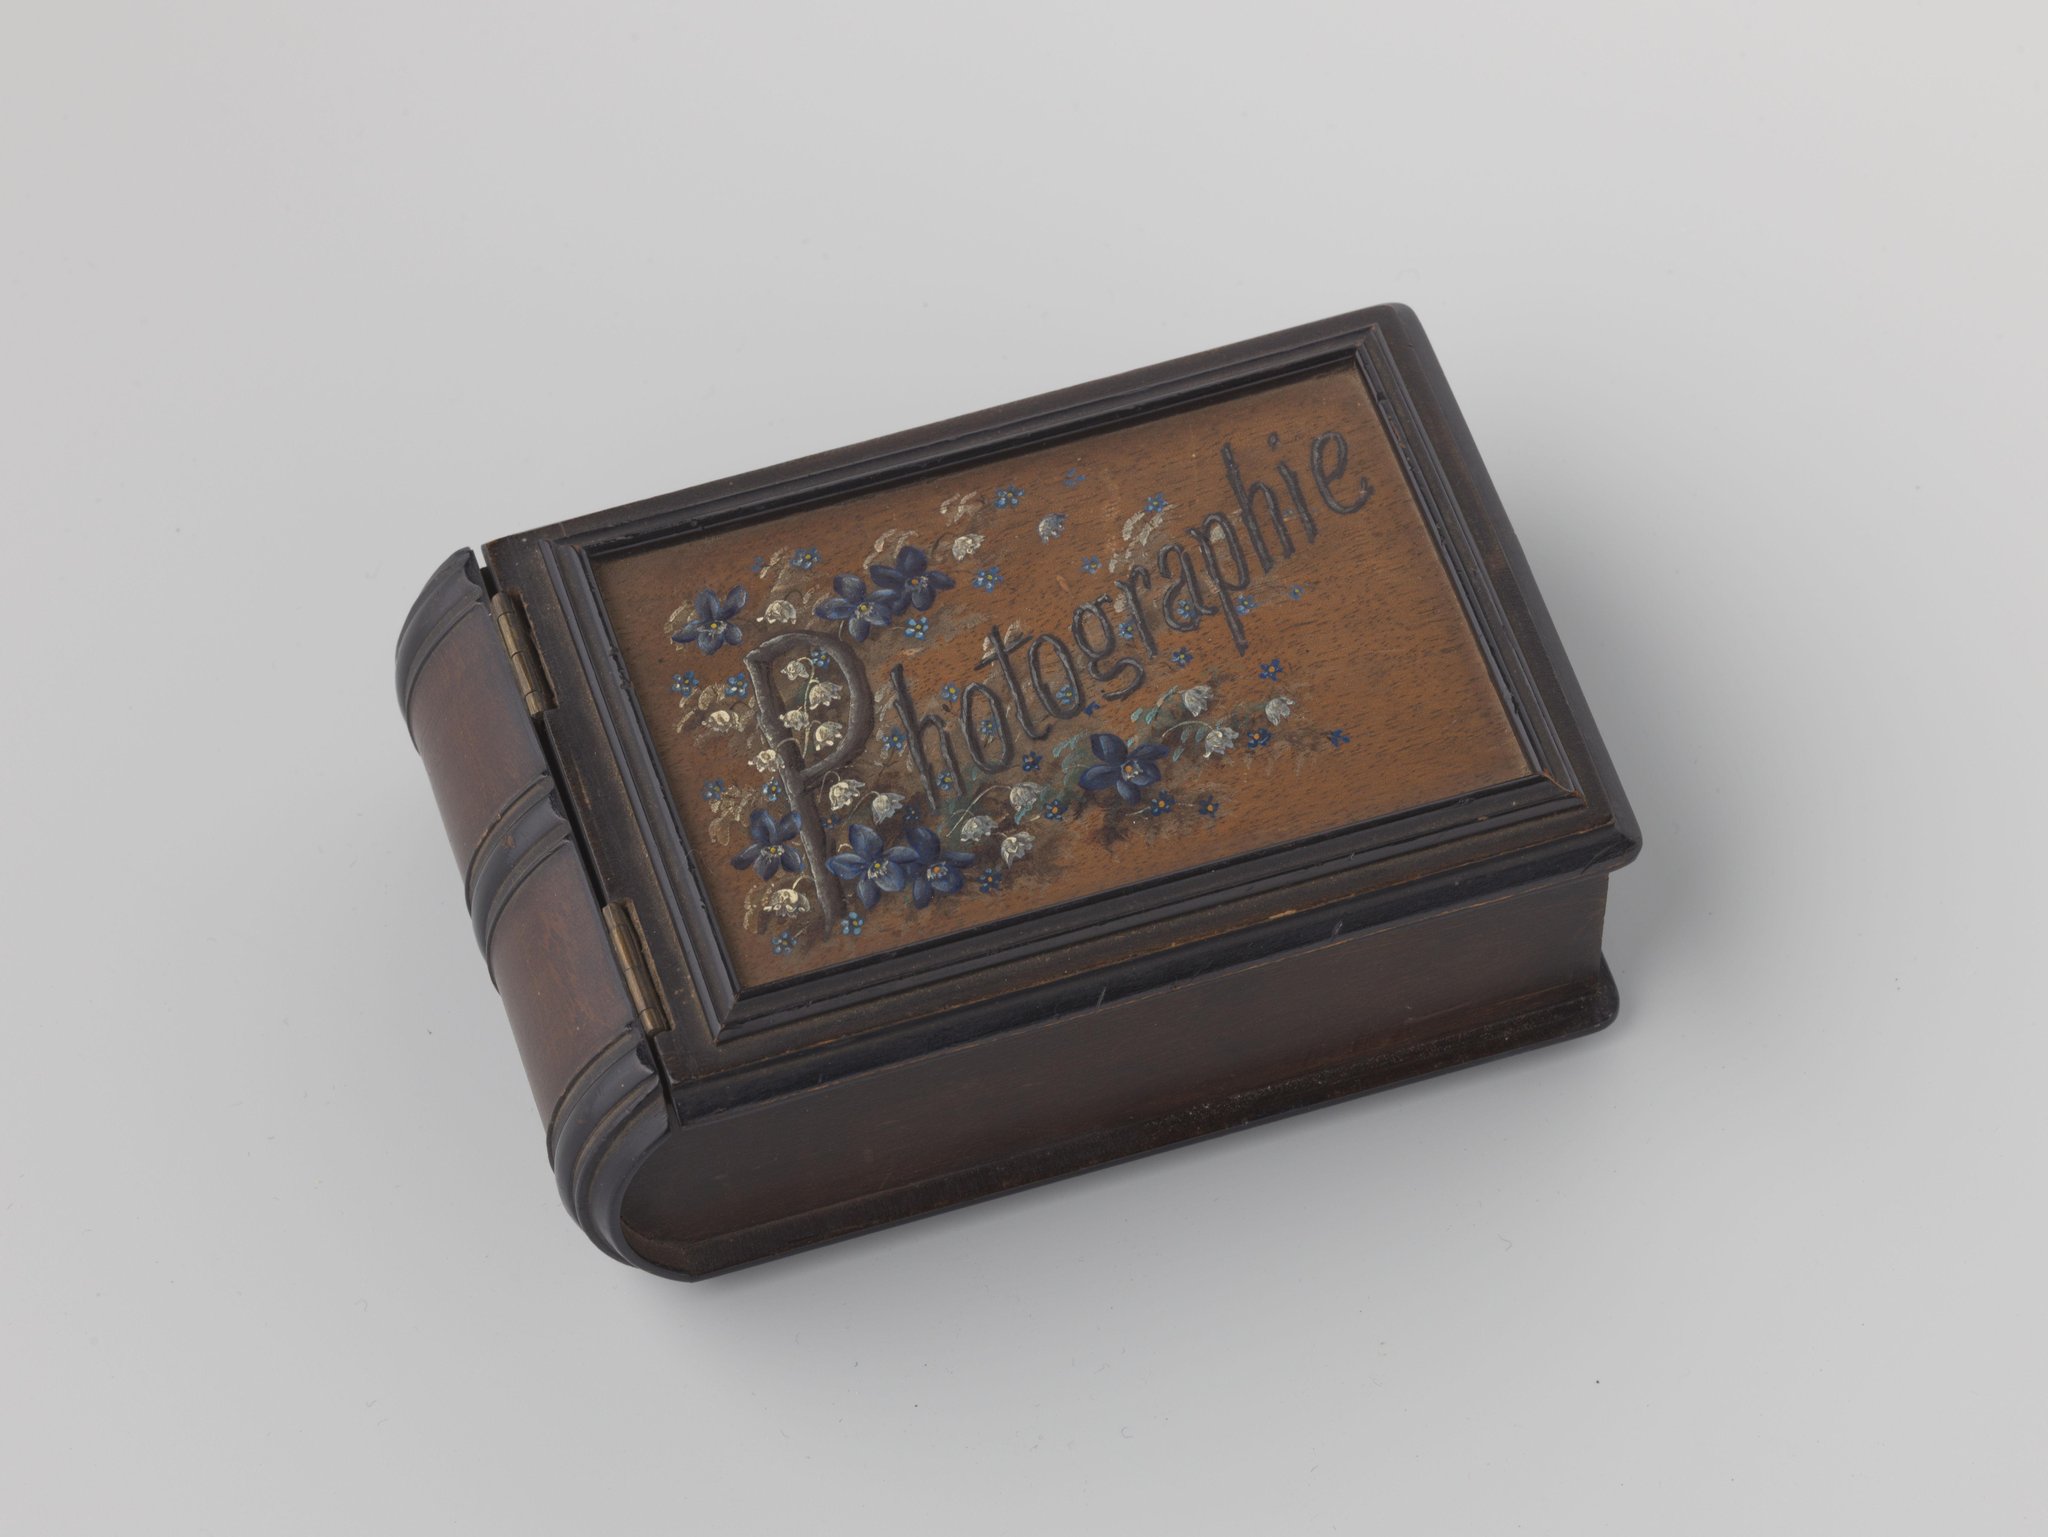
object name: box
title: Kist in de vorm van een boek, beschilderd met bloemen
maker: Anonymous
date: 1880-1900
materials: metal, textile, wood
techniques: brush